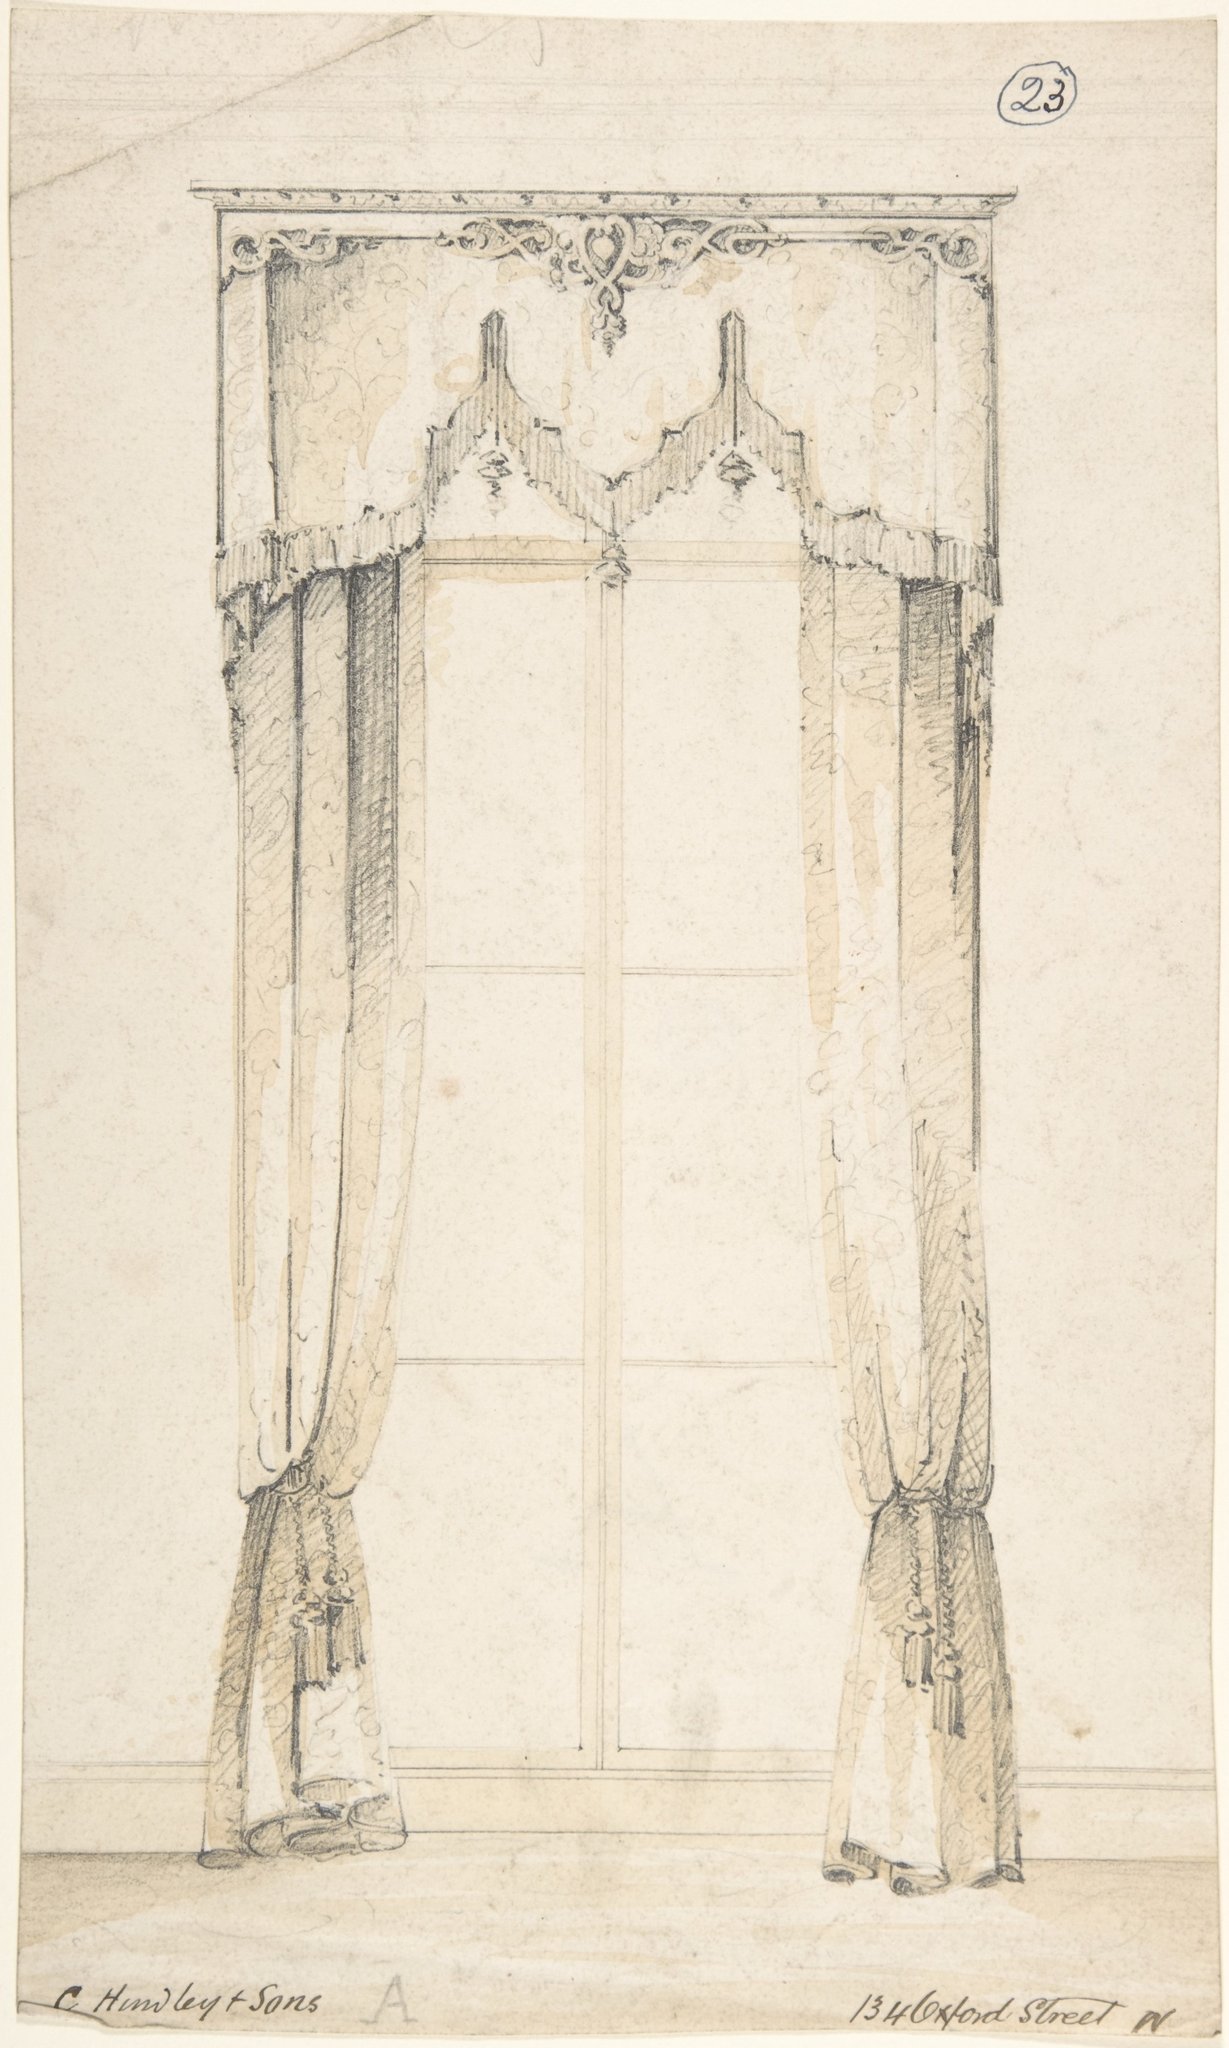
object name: drawing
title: Design for Curtains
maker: charles hindley and sons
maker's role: artist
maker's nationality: british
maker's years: 1841-1917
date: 1841-1884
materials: graphite, watercolor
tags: curtains